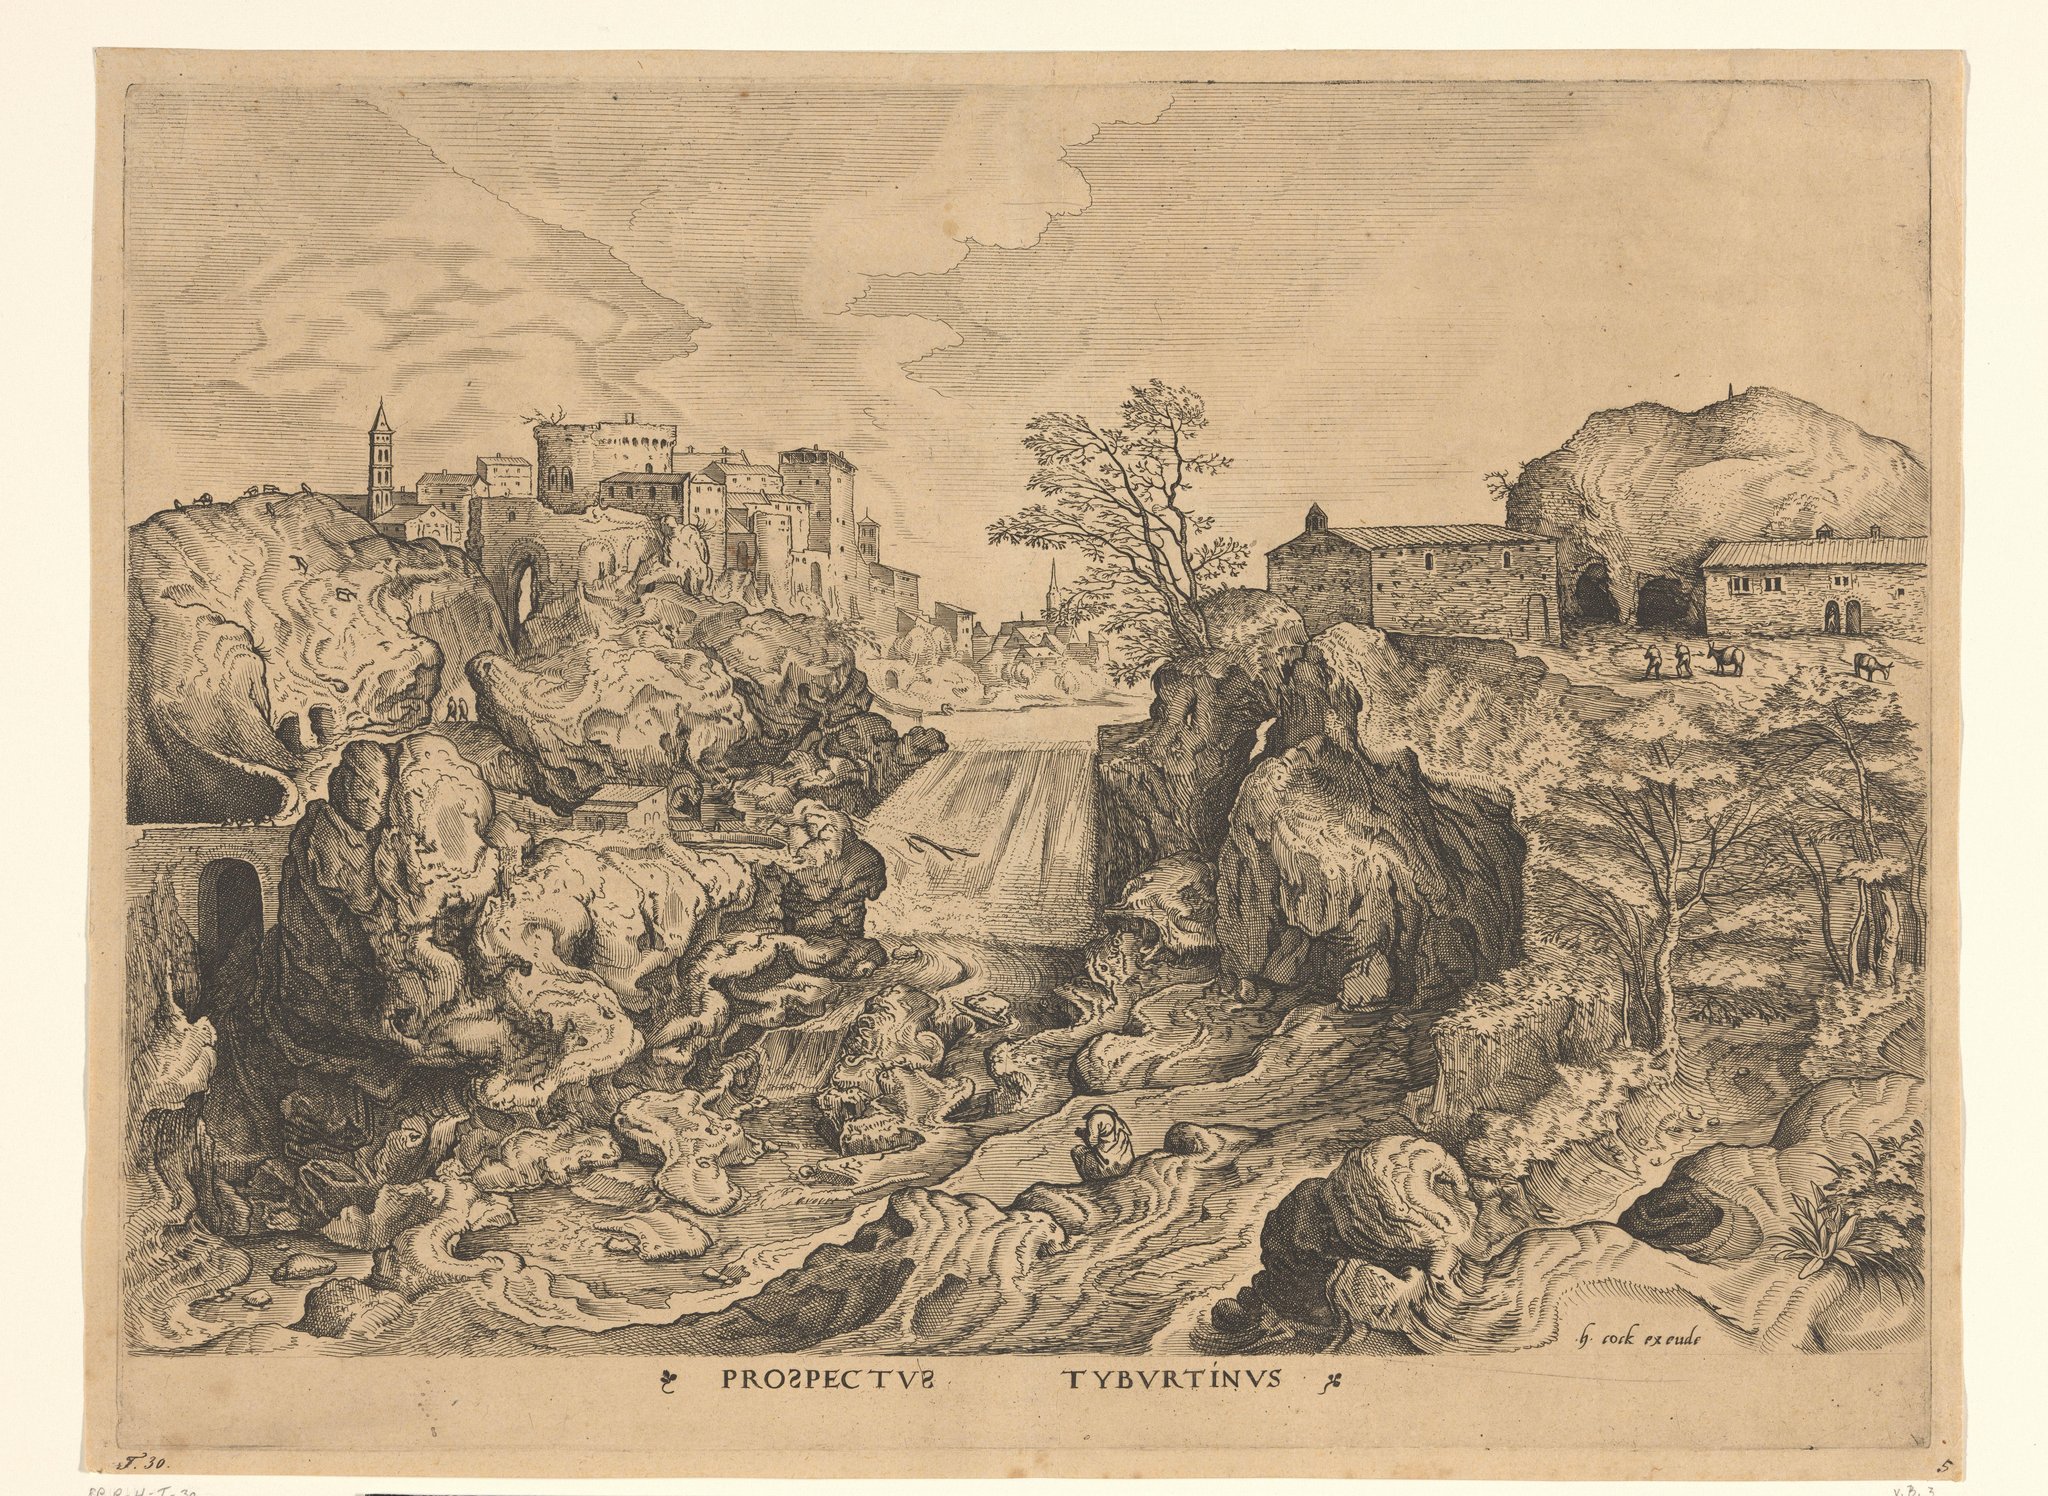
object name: print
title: Prospectus Tyburtinus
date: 1553-1558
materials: paper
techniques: engraving, etching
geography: antwerp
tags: river, landscapes in the temperate zone, tivoli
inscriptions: inscription: ‘T.30.’, collector's mark: Lugt 11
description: Gezicht op de rivier de Tiber bij Tivoli. In het midden van het landschap een waterval. Links Tivoli.